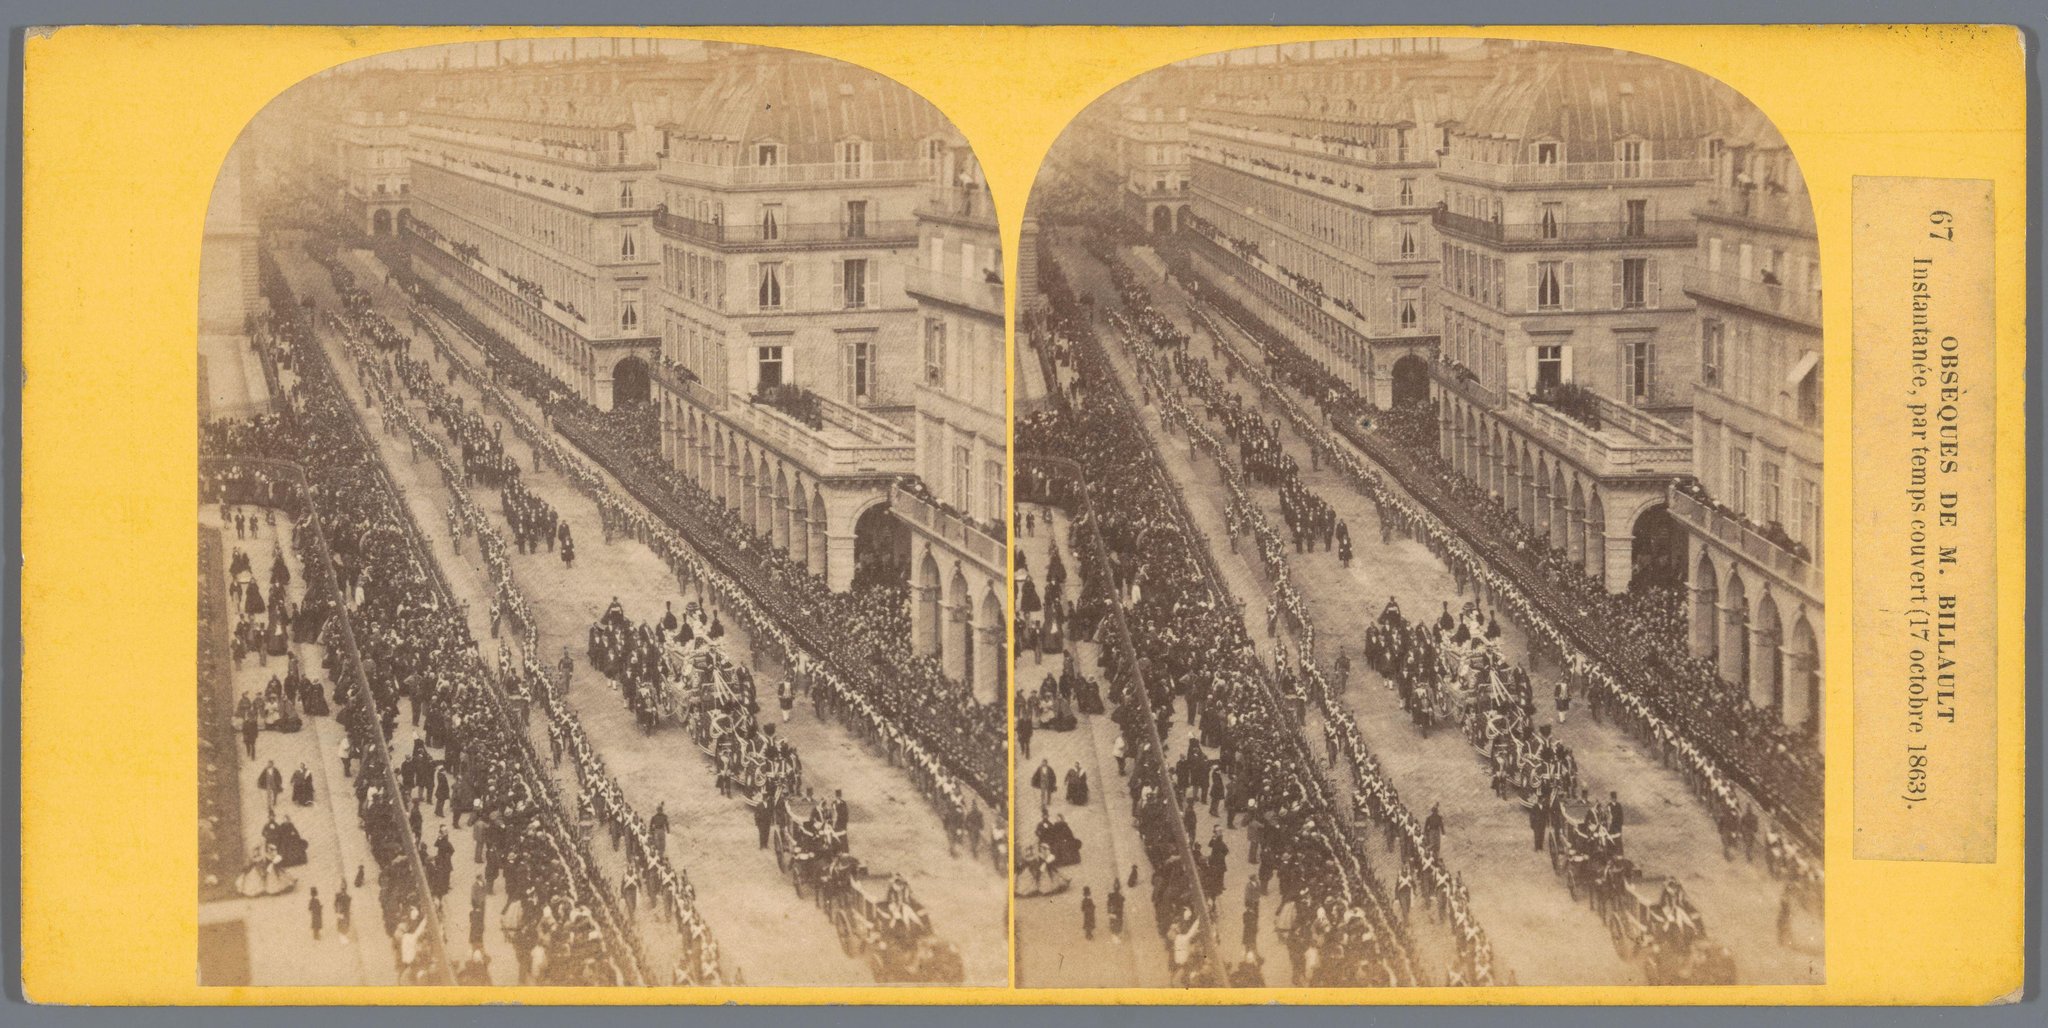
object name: stereograph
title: Obsèques de M. Billault, Instantanée, par temps couvert (17 octobre 1863)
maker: Anonymous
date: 1863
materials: cardboard, photographic support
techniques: albumen print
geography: paris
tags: politician, public funeral, paris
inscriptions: number: ‘67’